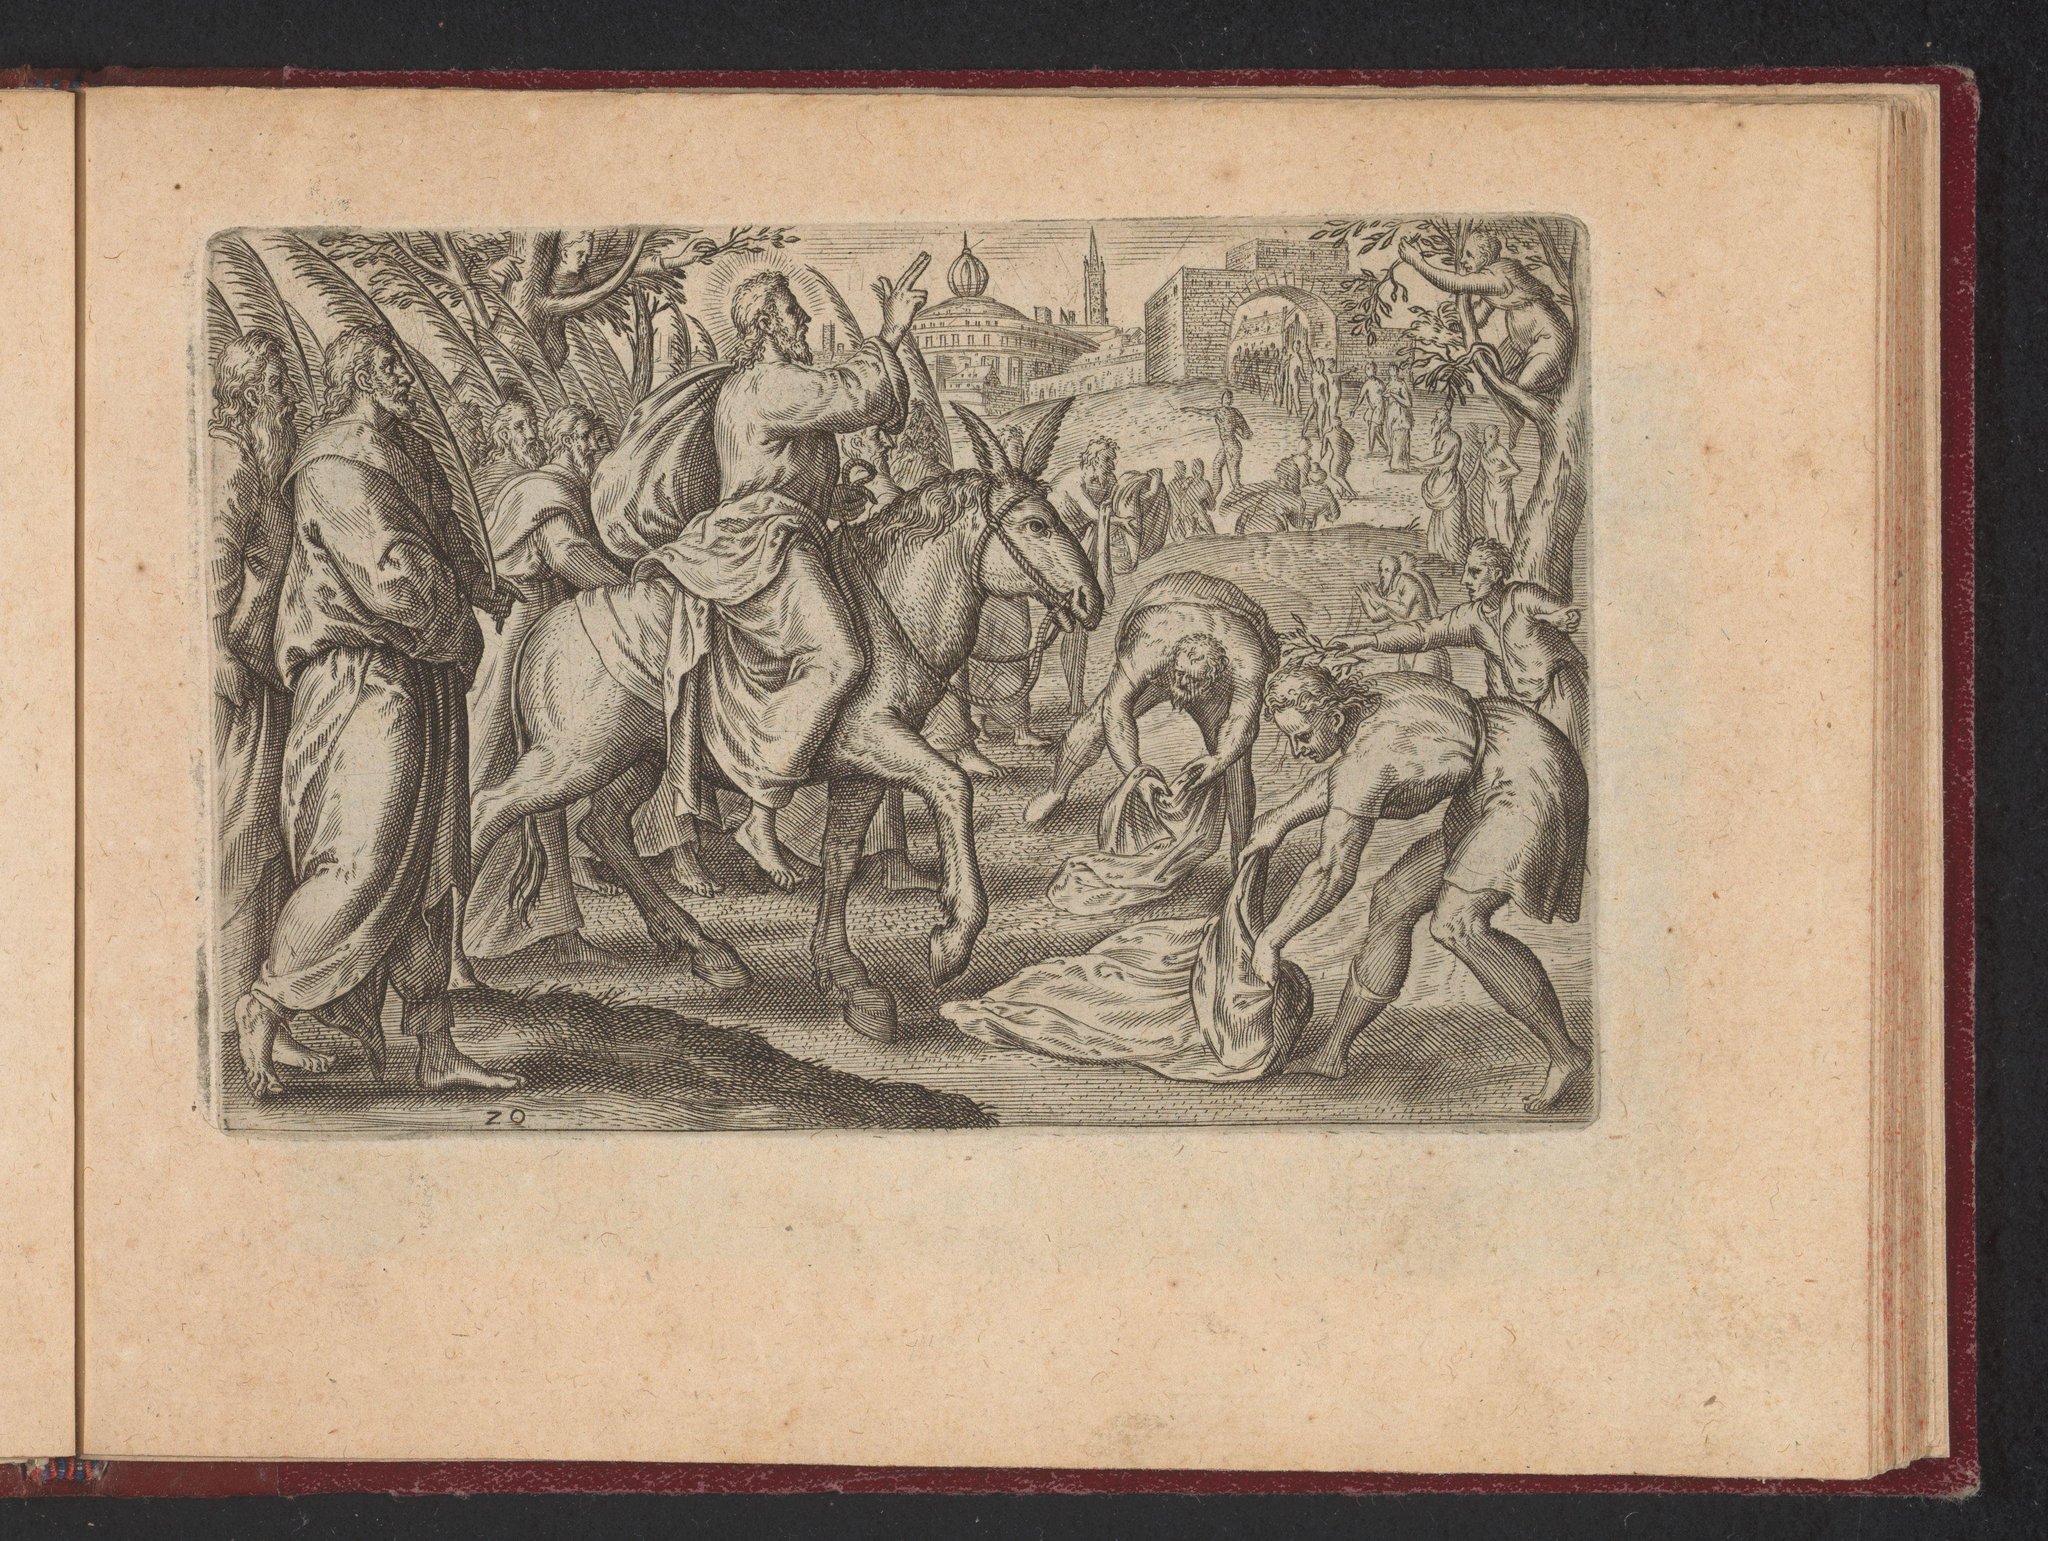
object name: print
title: Intocht in Jeruzalem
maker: philips galle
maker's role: print maker, publisher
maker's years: 1537-1612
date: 1573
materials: paper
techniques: engraving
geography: antwerp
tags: entry into jerusalem: people spreading their clothes before christ on the ass, and waving palm branches (matthew 21:1-11, 21:14-16; mark 11:1-11; luke 19:28-40; john 12:12-19)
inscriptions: watermark: ‘gotische letter P’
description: Onderdeel van een album met een titelprent en een serie van 50 prenten betreffende het leven en de passie van Christus.